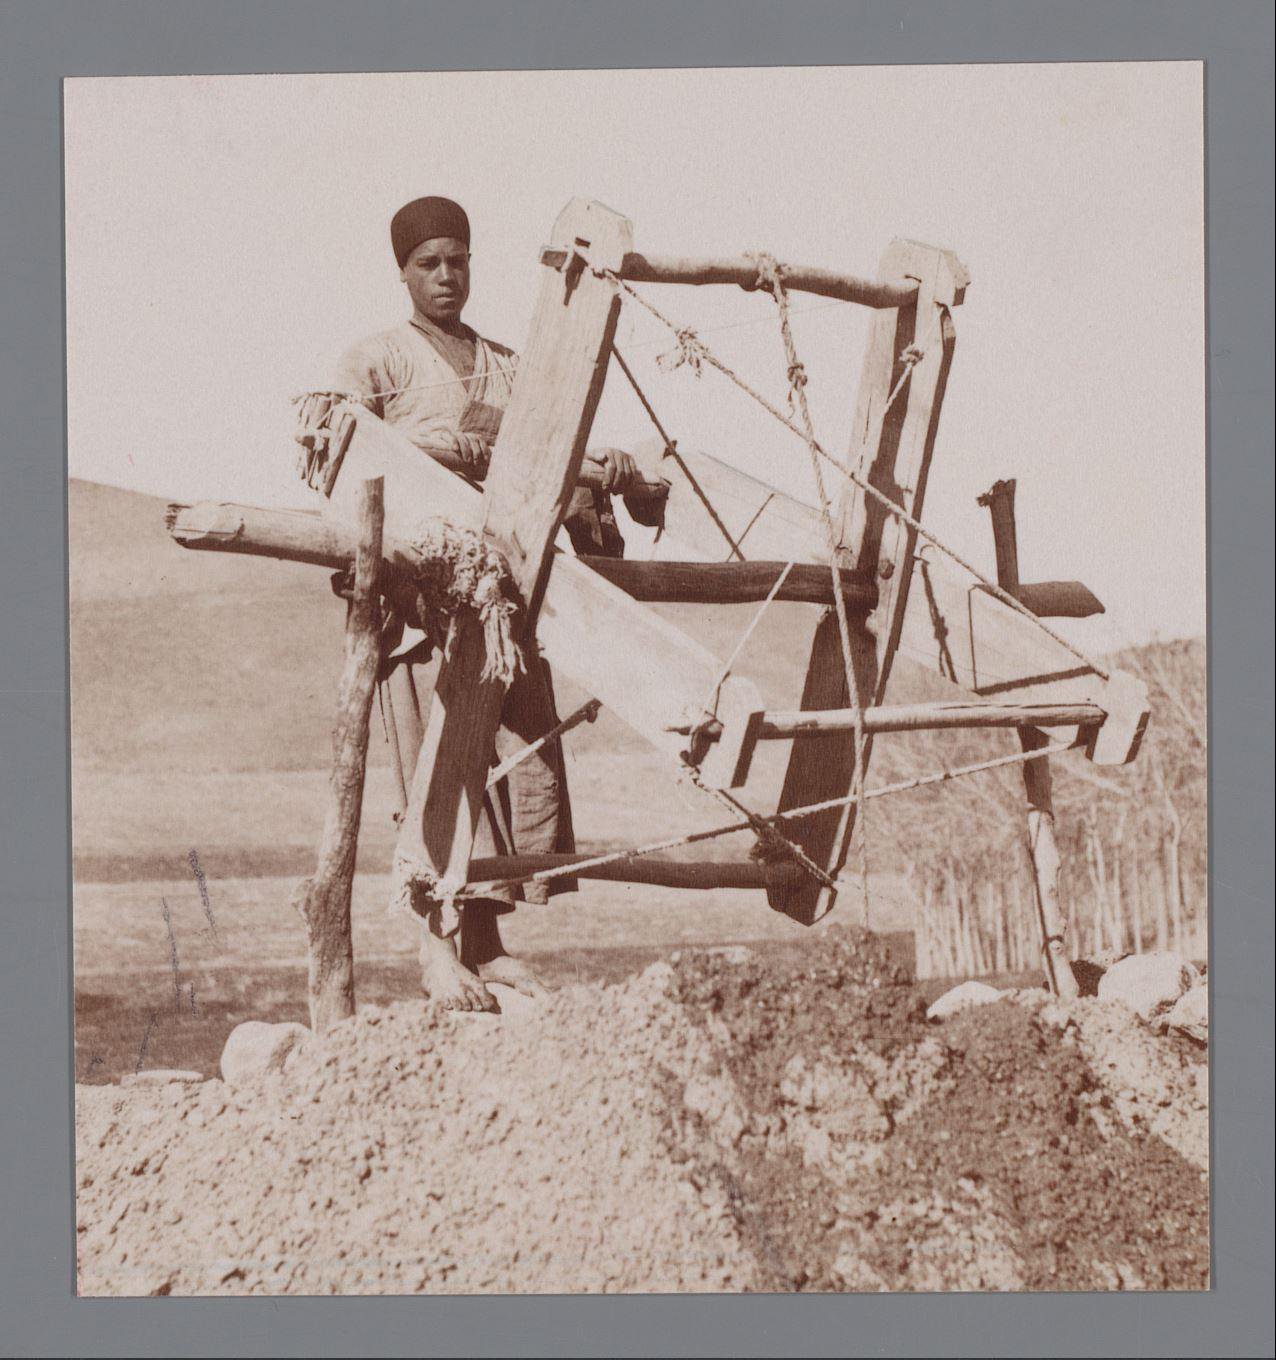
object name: photograph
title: Landschap met jongen met een ploeg/gereedschap [?], Iran [?]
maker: antoine sevruguin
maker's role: fotograaf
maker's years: 1840-1933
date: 1880-1910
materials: paper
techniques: albumen print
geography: iran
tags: iran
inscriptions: number: ‘9’, number: ‘997’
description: Landschap met jongen met een ploeg/gereedschap [?], Iran [?].